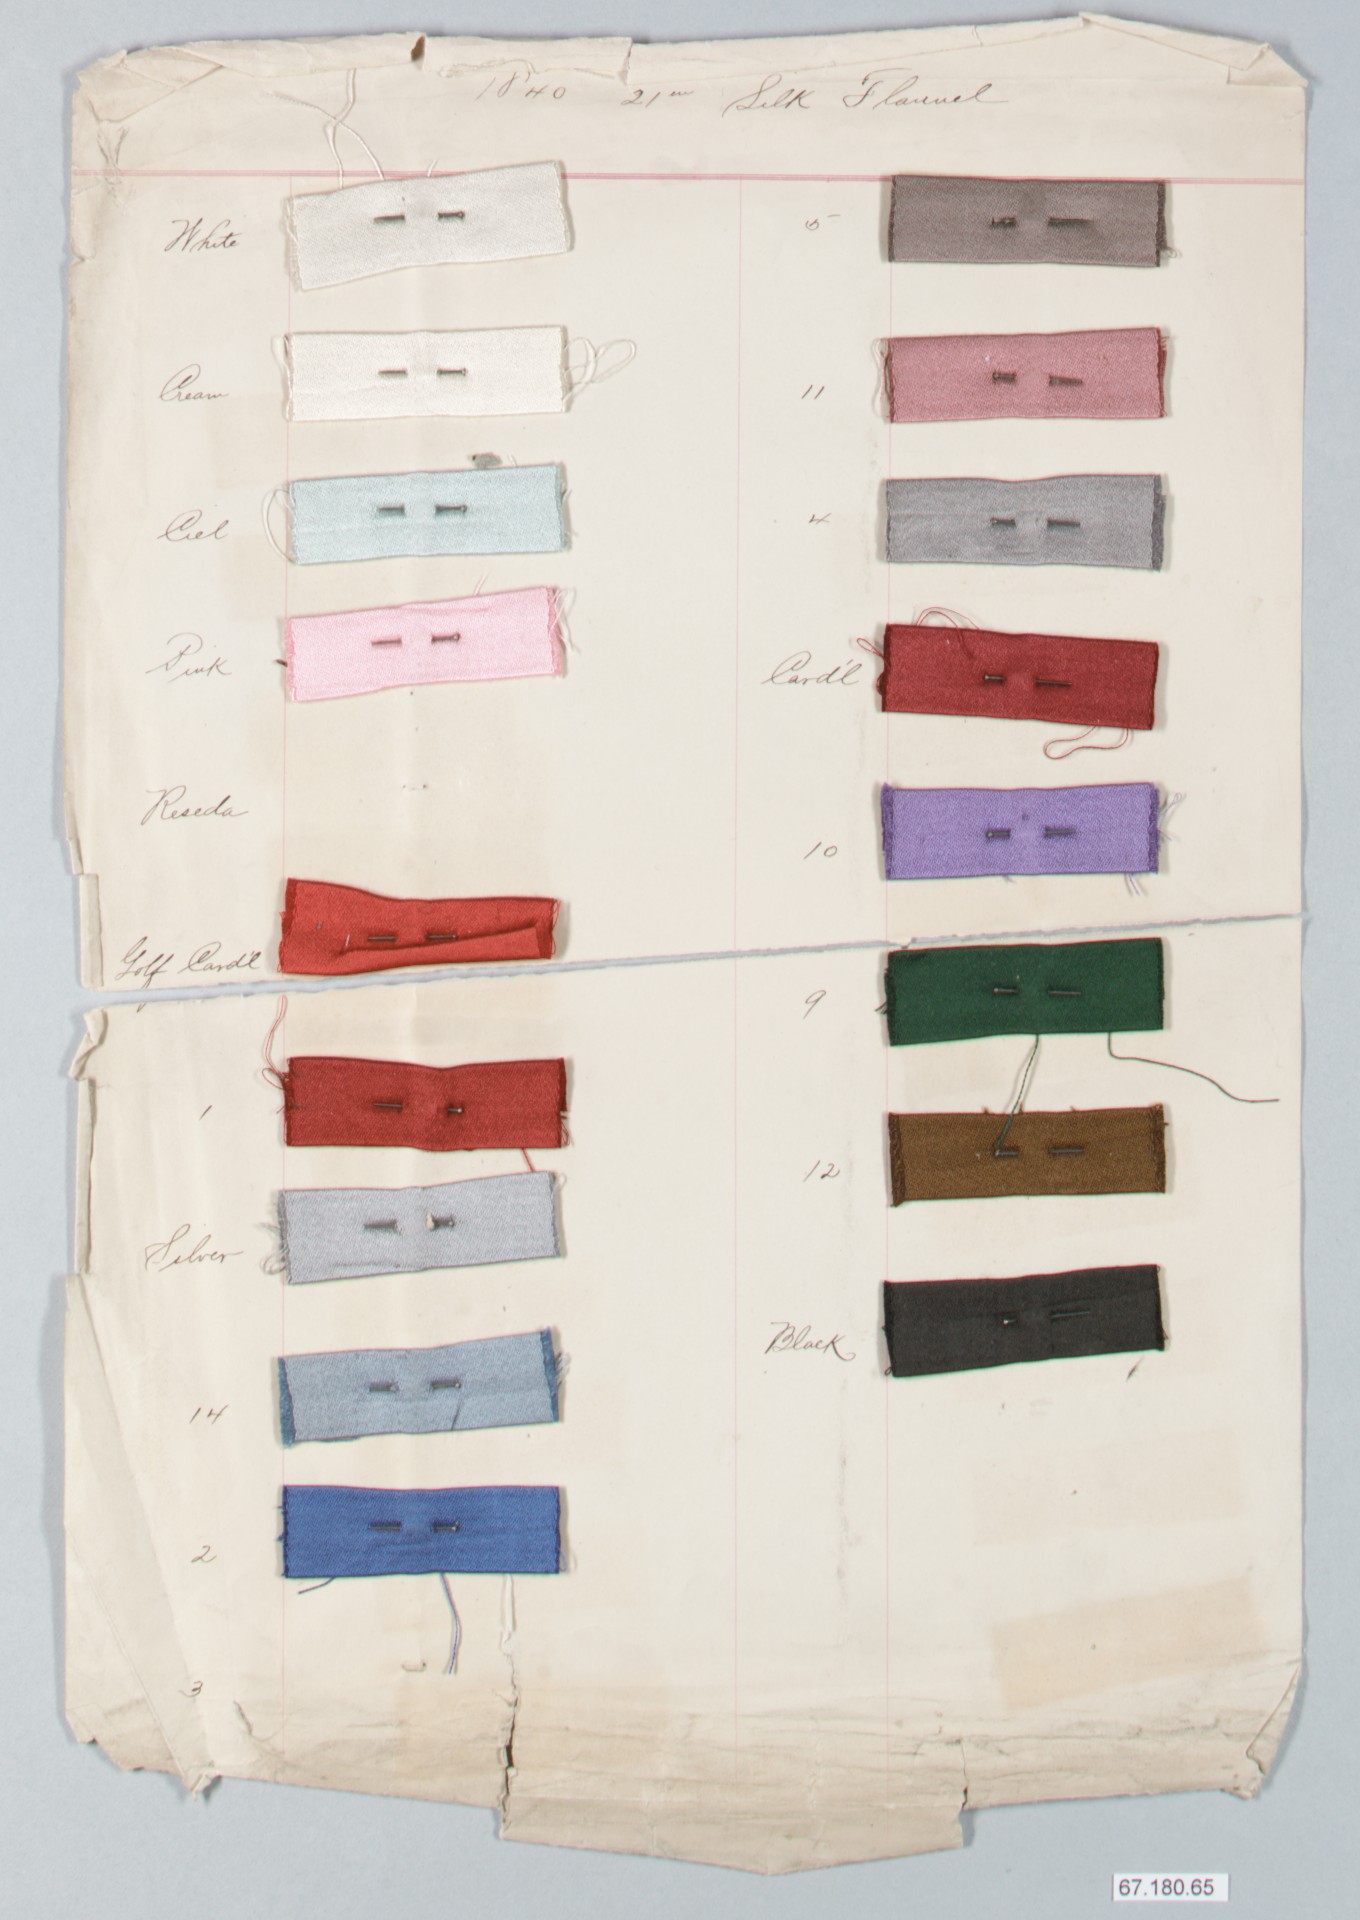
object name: sample book page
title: Page from a sample book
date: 1840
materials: silk